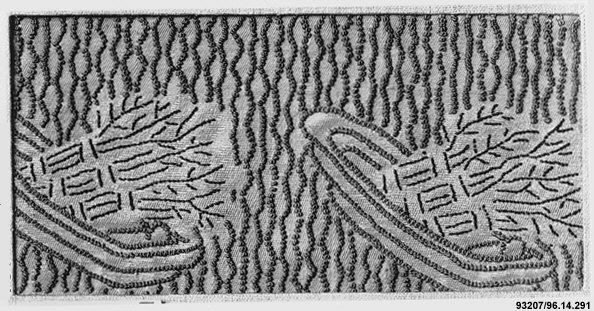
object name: piece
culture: japanese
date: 1701-1900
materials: silk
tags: boats